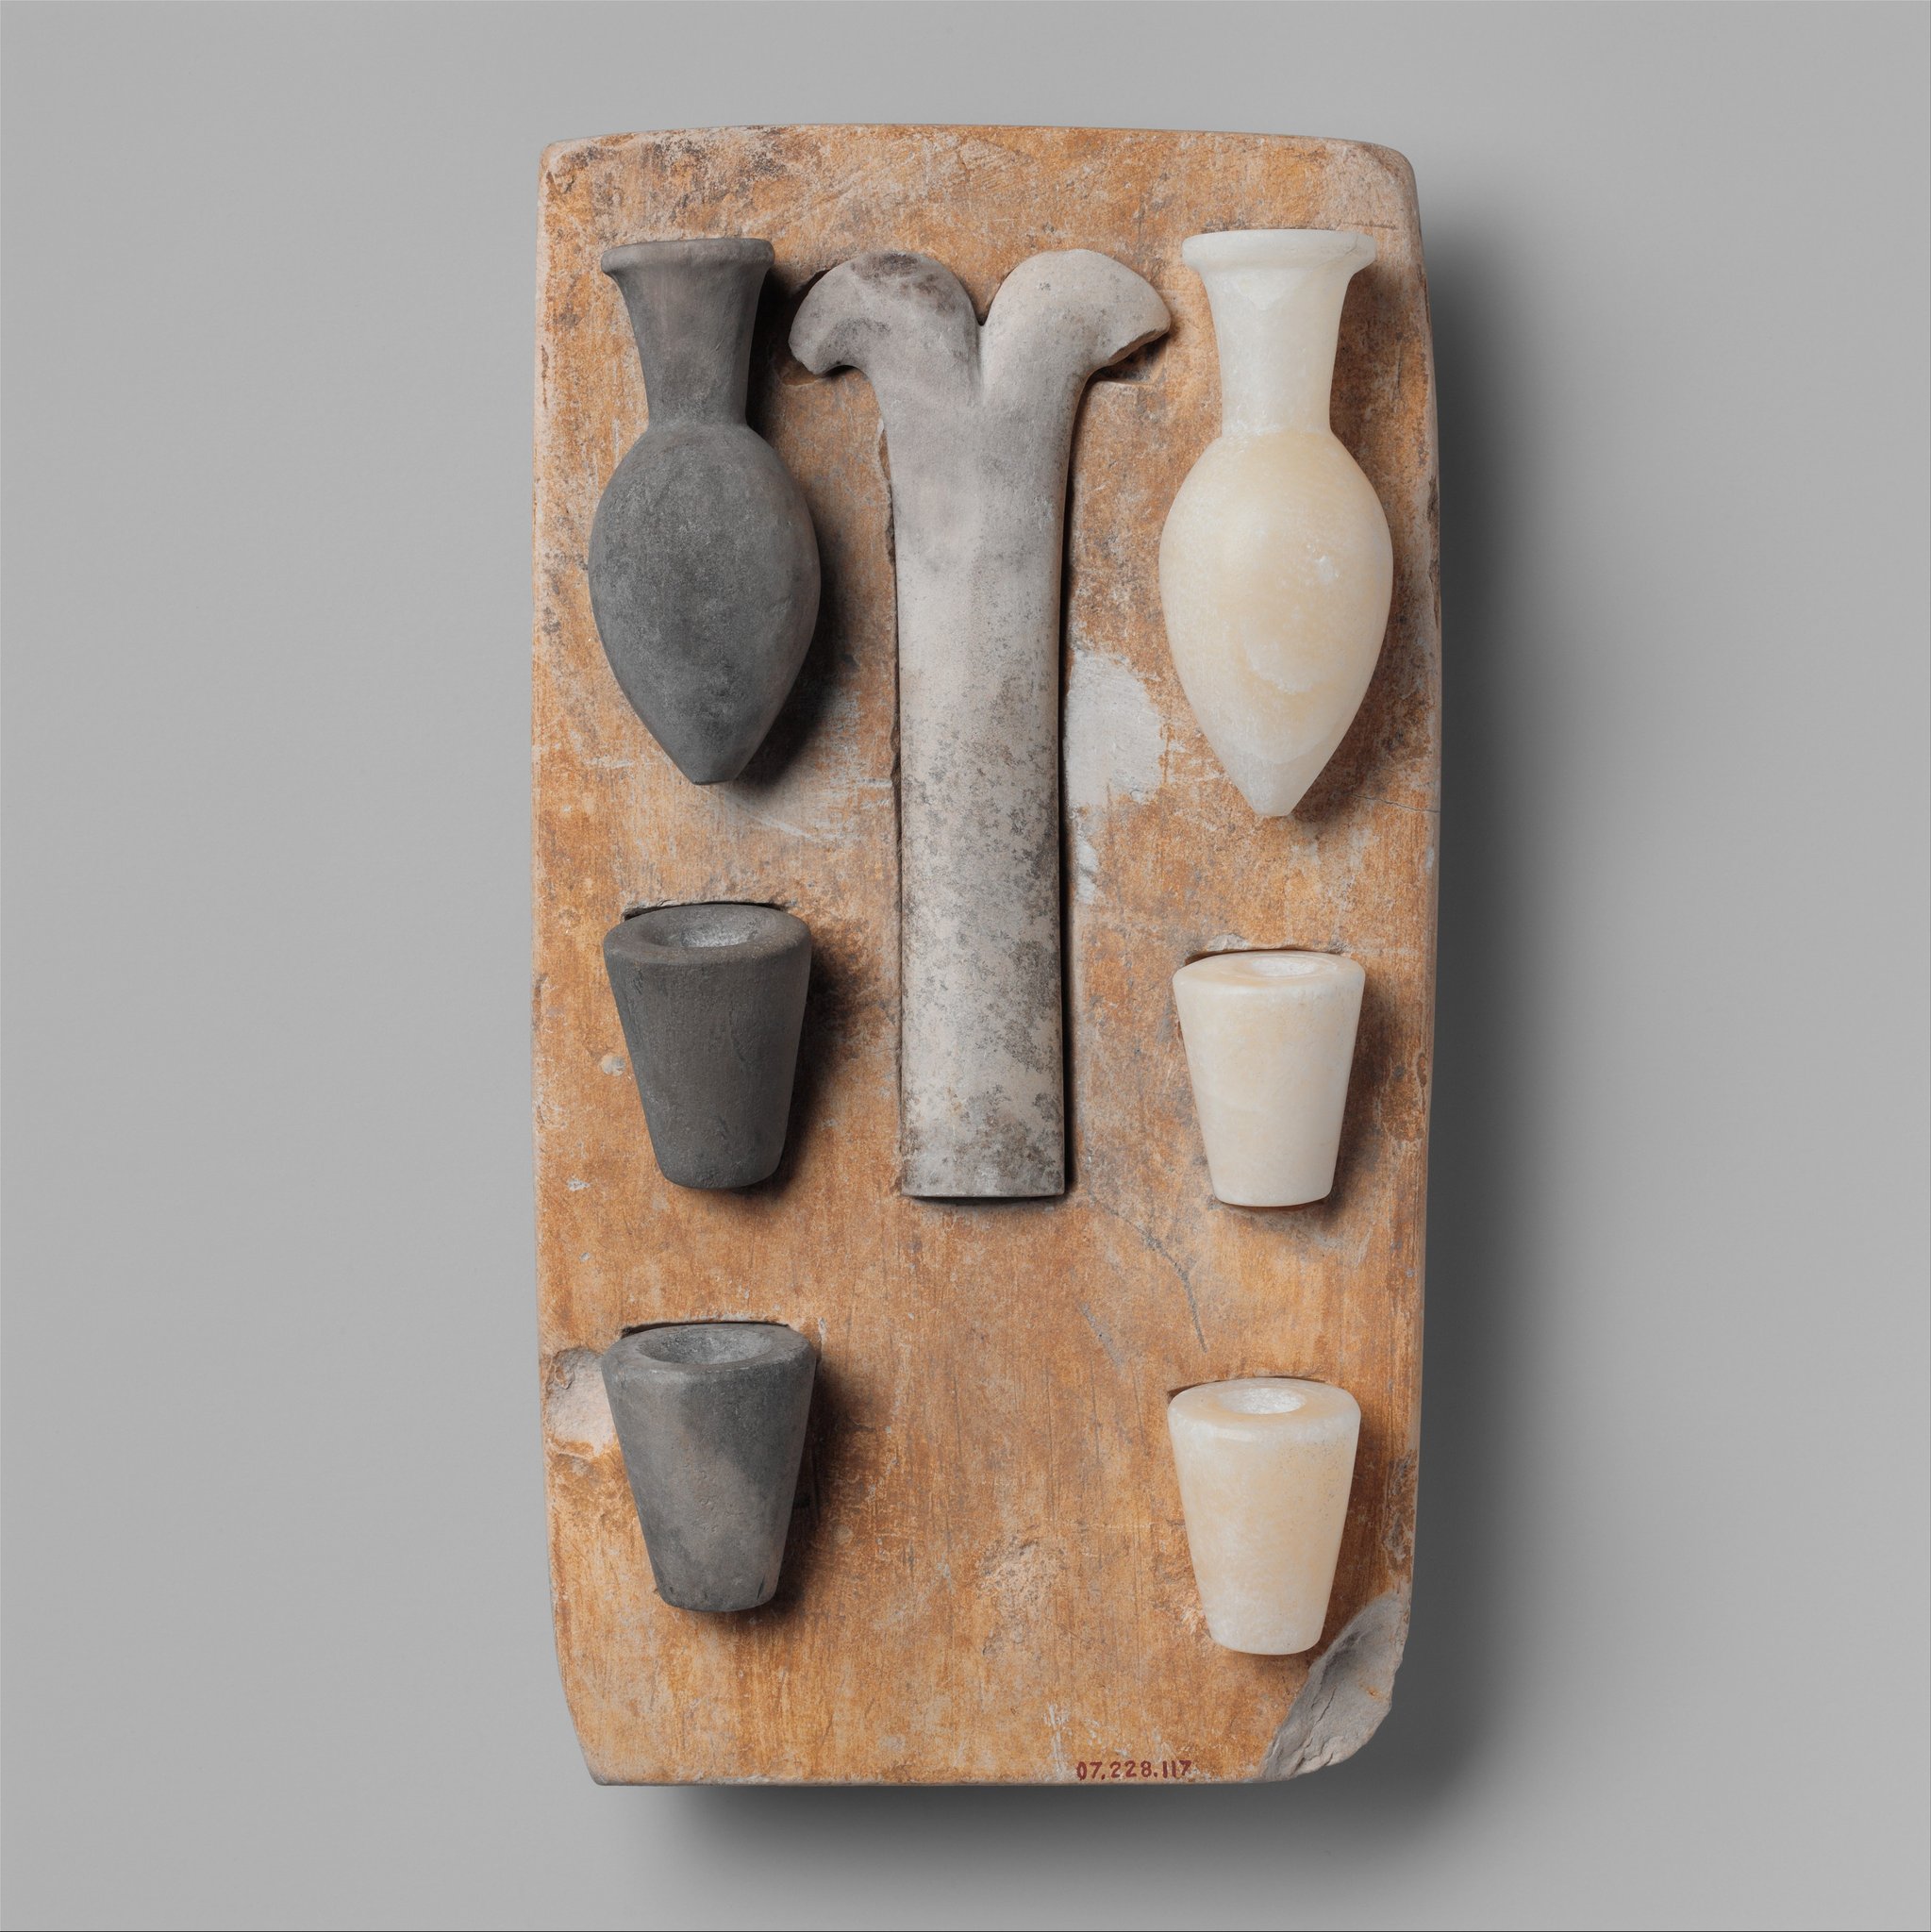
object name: model, opening of the mouth ritual equipment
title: Model of the "Opening of the Mouth" ritual equipment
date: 2465-2150 BCE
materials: limestone, stone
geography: egypt